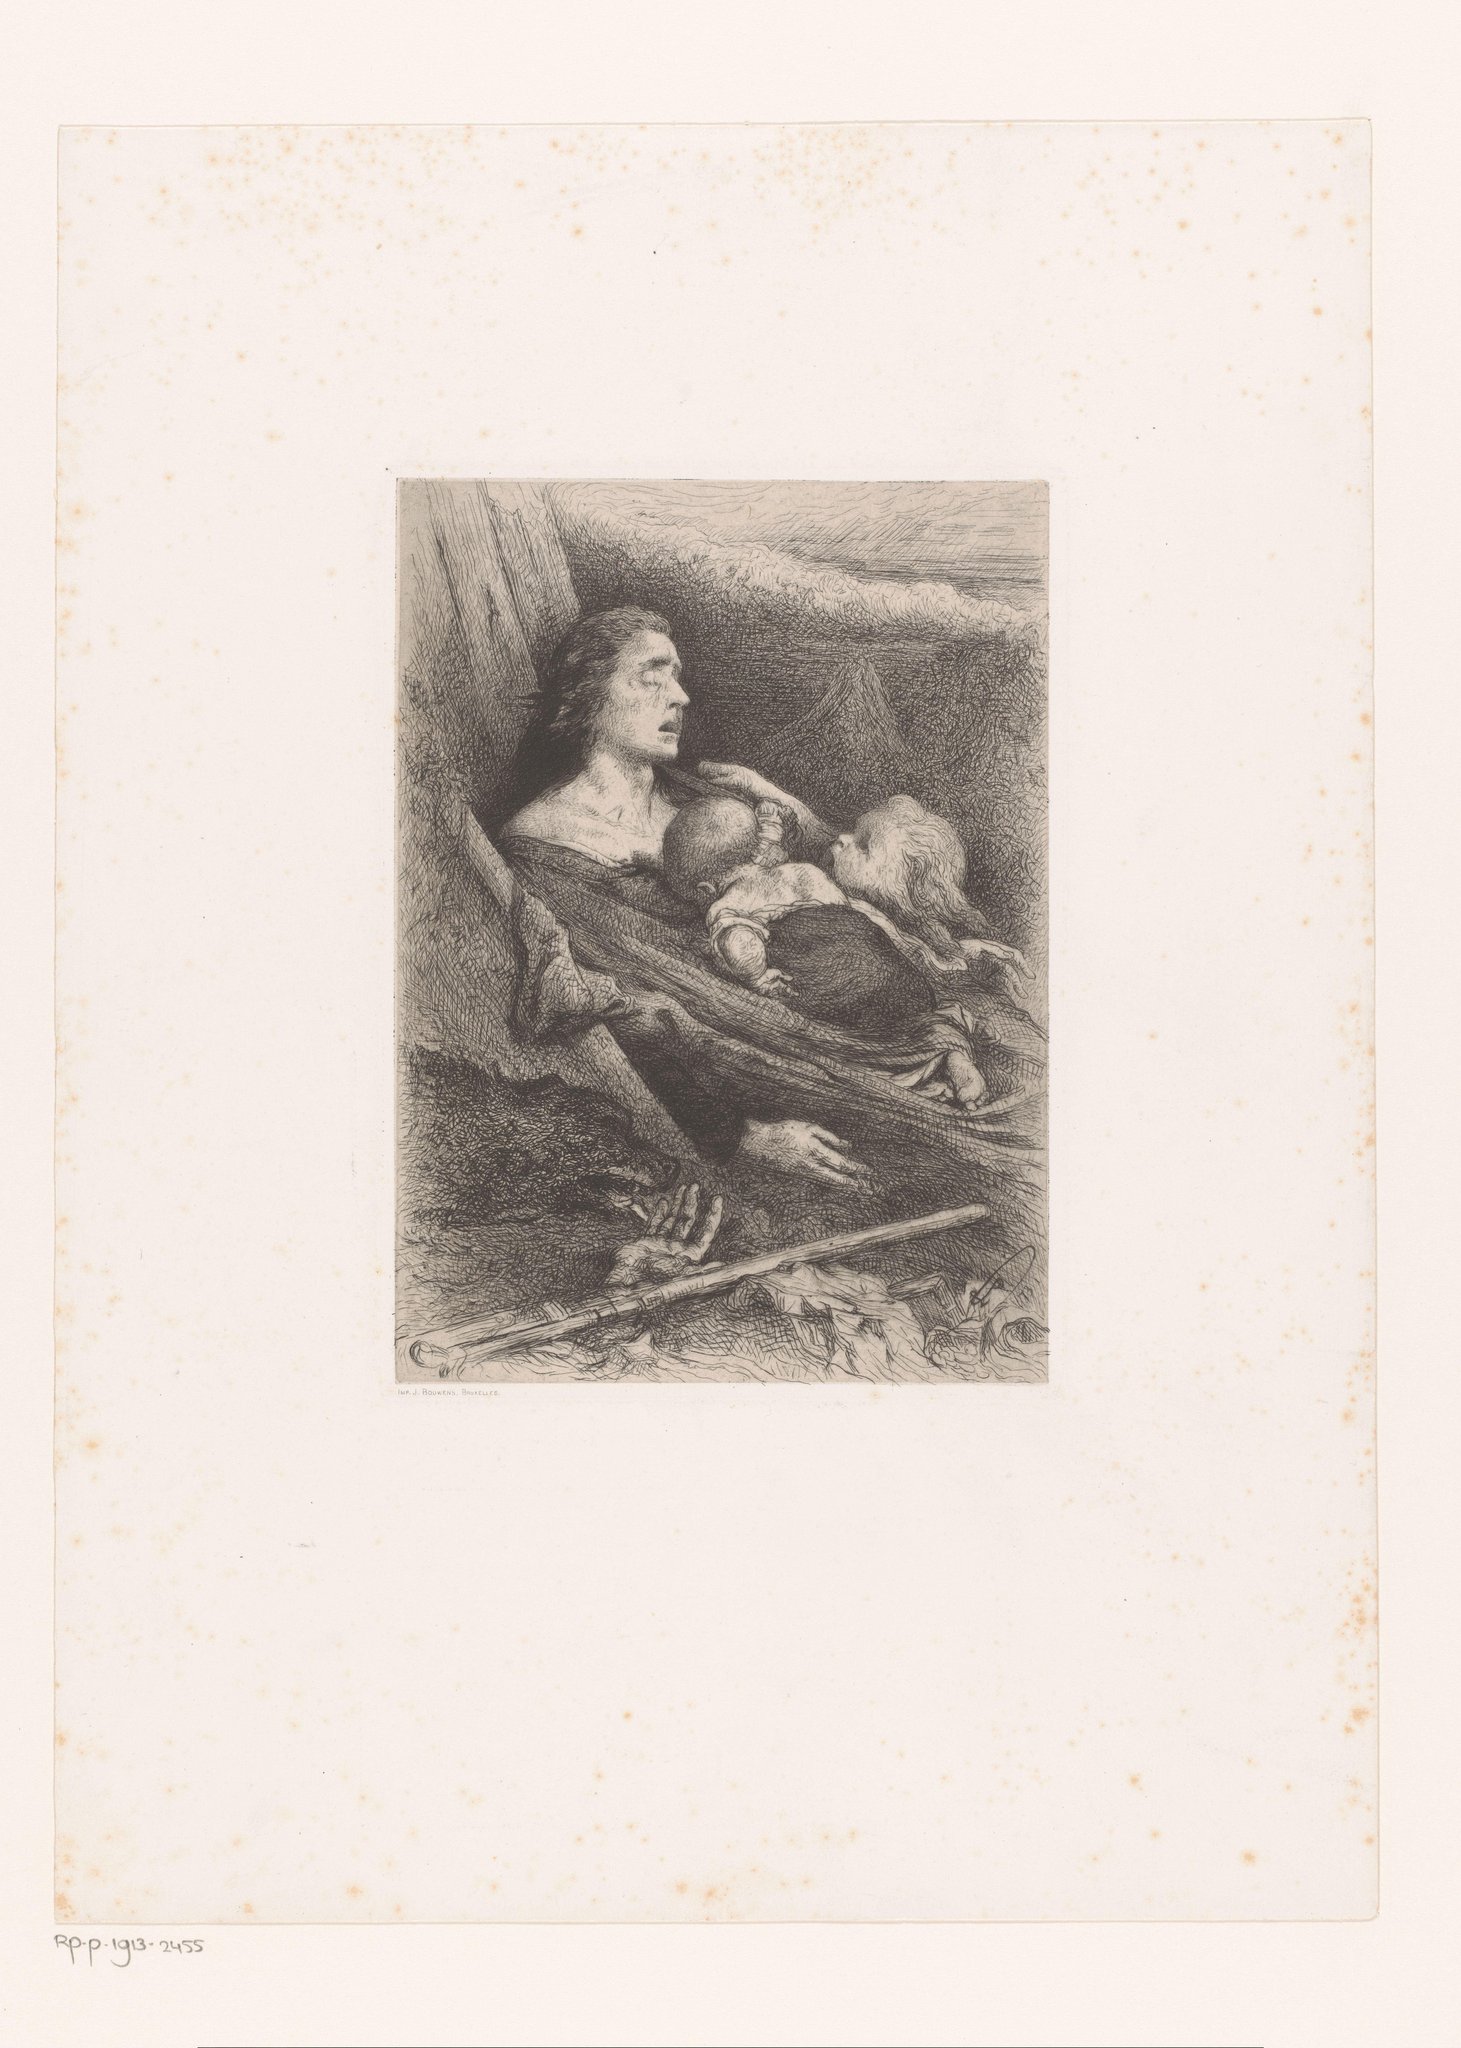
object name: print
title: Allegorie op oorlog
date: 1873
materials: paper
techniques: drypoint, etching, intaglio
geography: brussels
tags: horrors of war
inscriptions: collector's mark: Lugt 2228